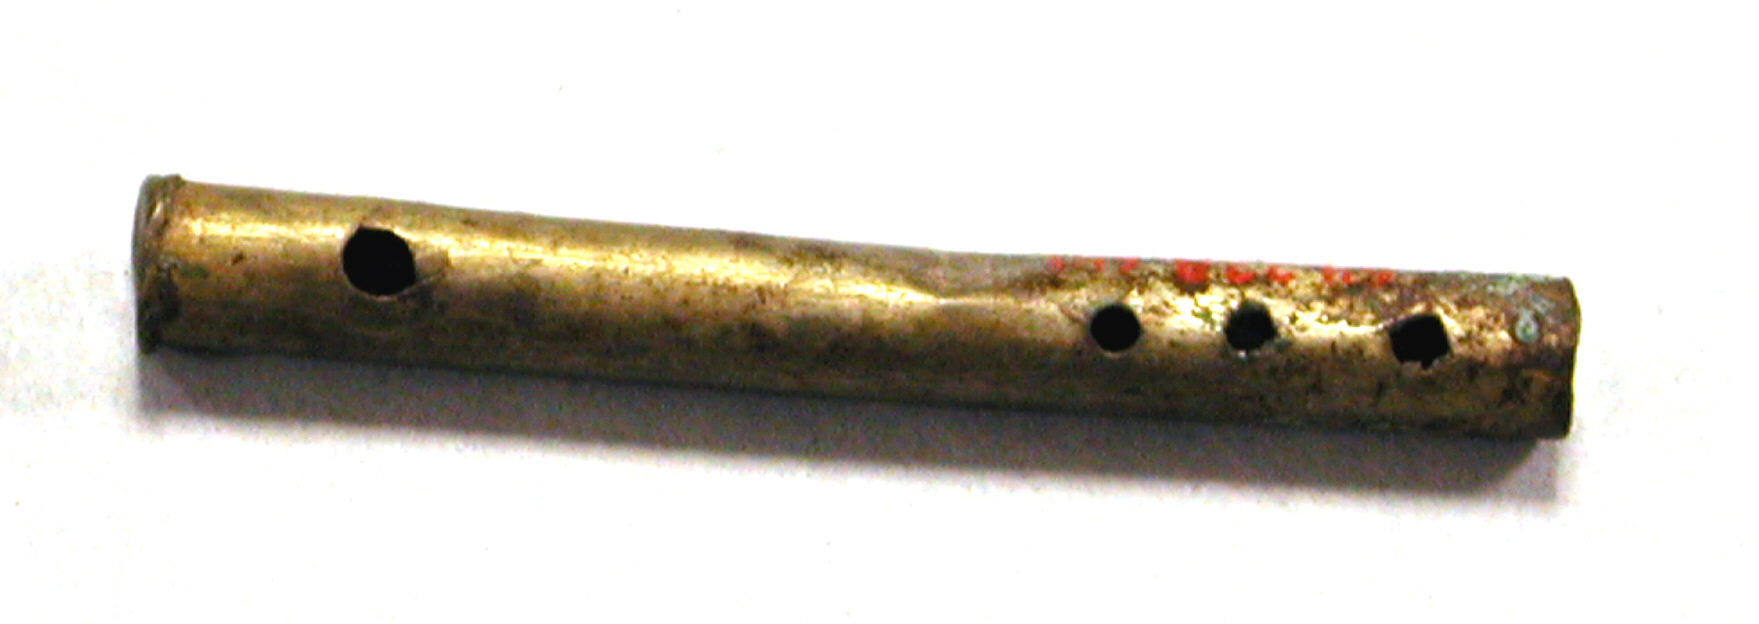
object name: flute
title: Hammered Silver Miniature Flute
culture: peruvian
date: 701-1566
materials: gilt, silver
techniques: hammering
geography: peru